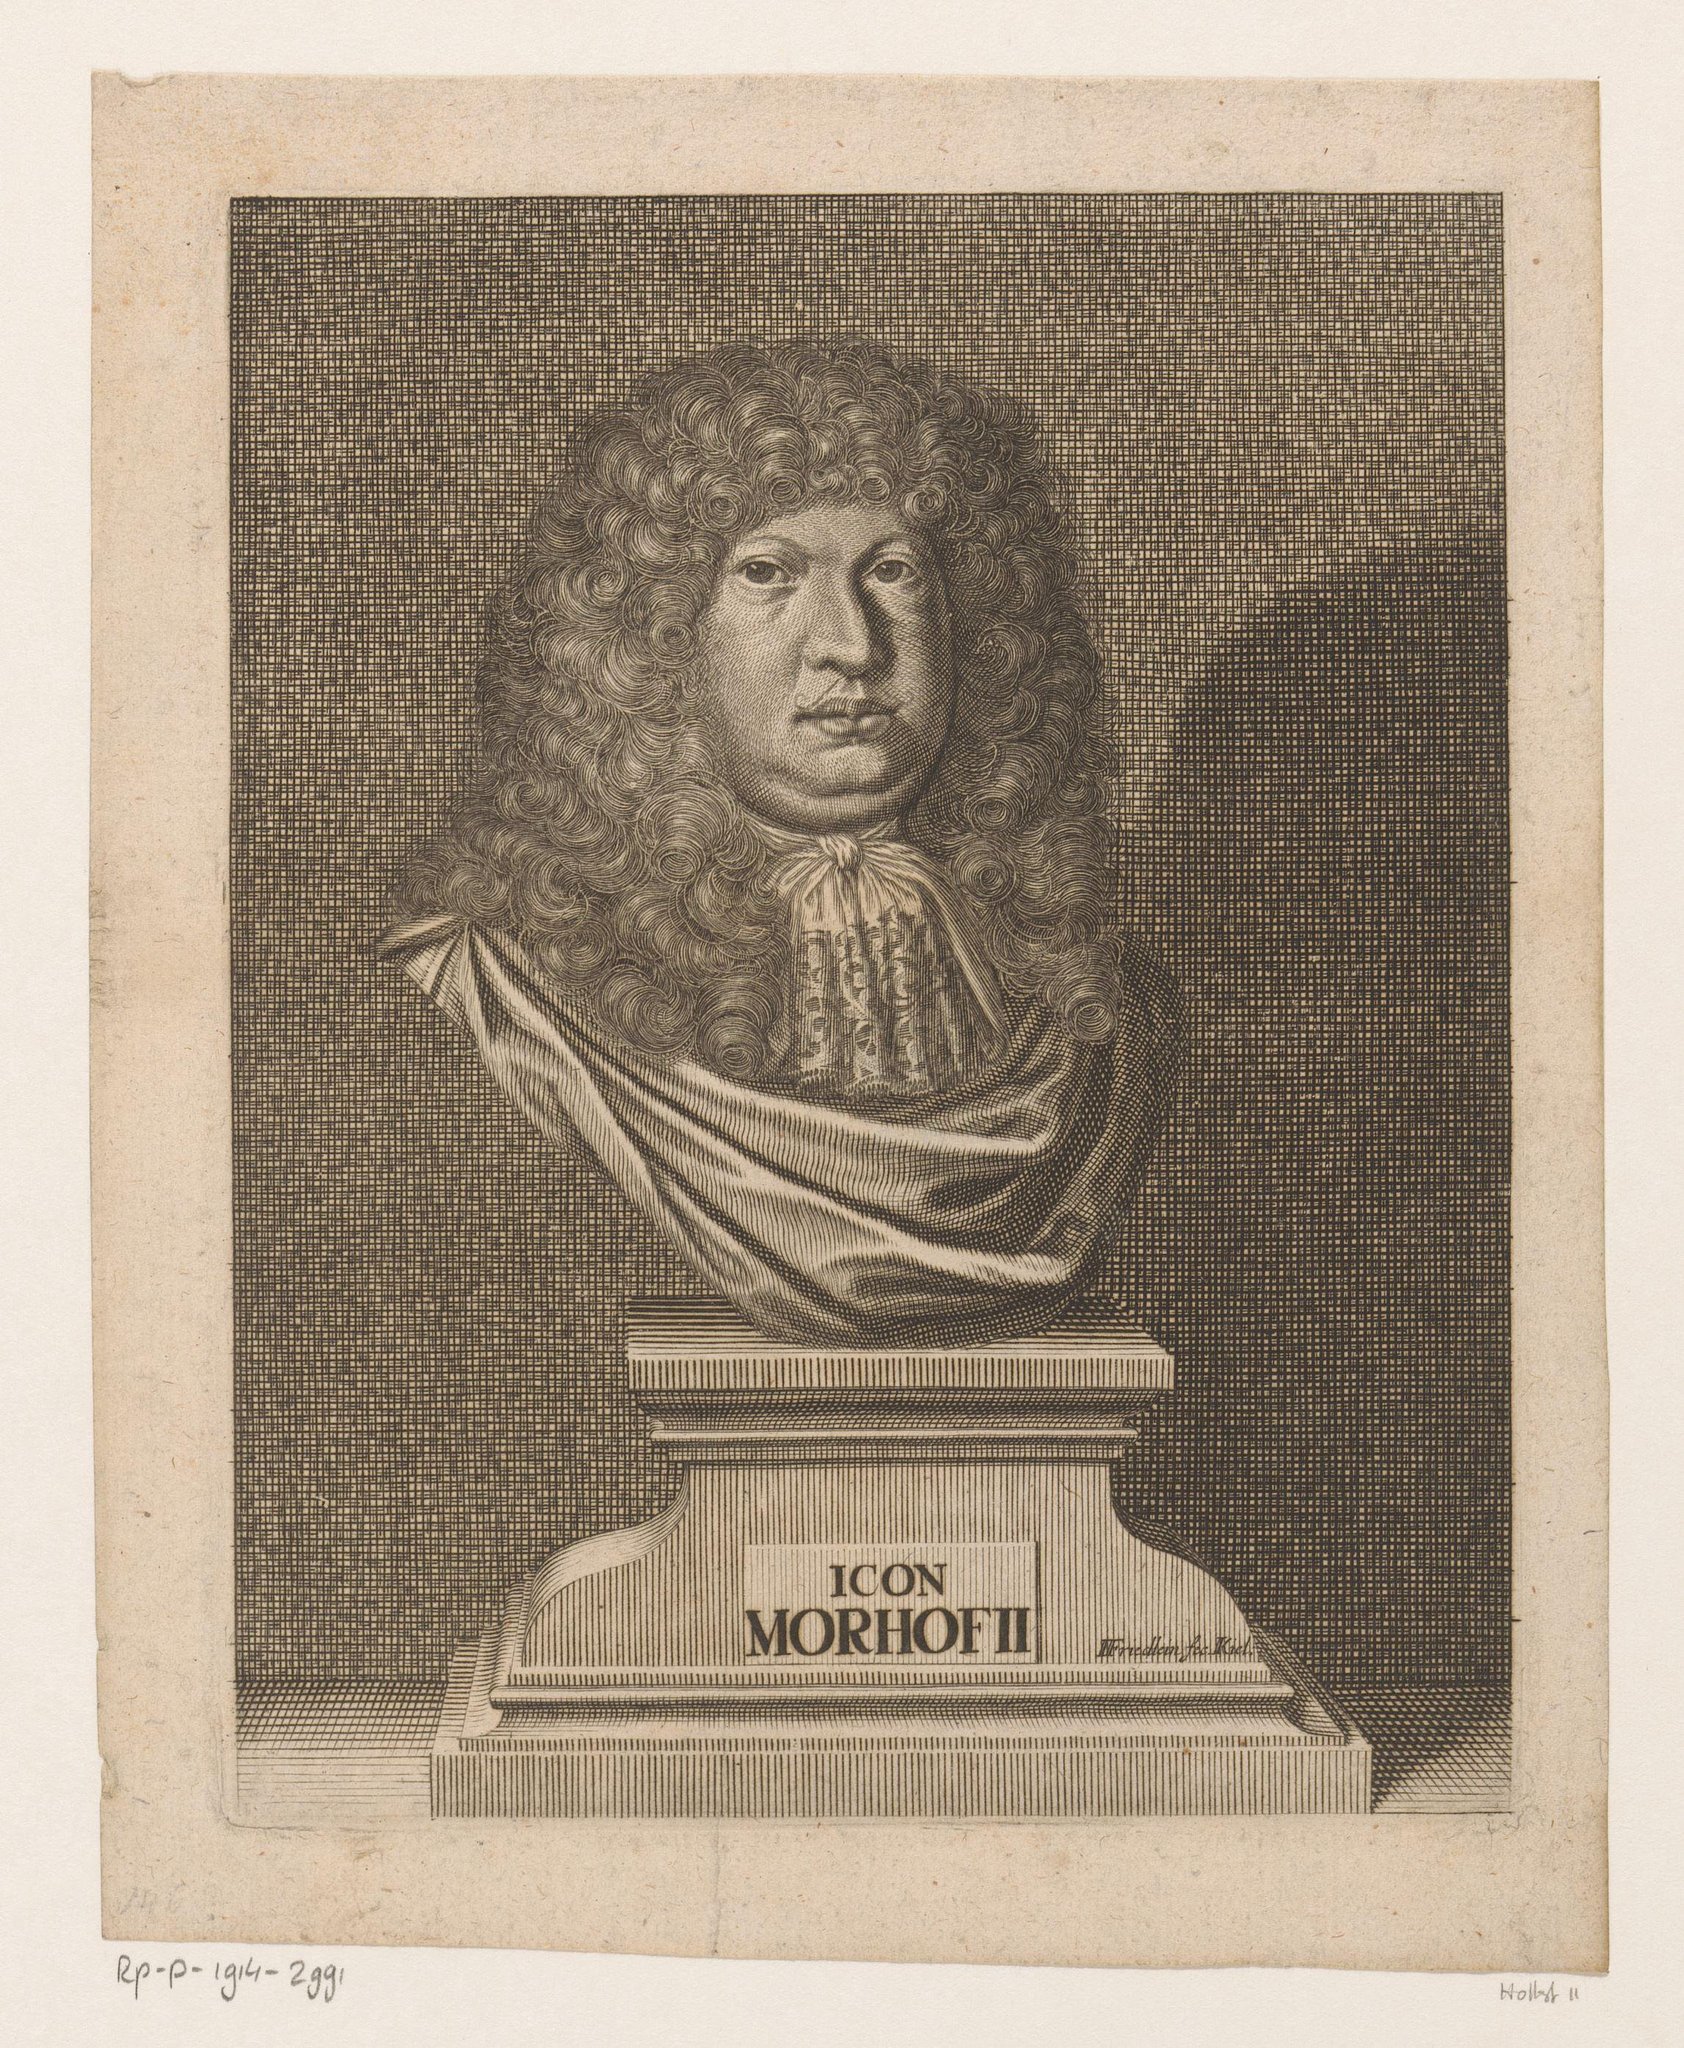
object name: print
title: Portret van Daniel Georg Morhof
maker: johann friedlein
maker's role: print maker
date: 1690-1695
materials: paper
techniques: engraving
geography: kiel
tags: daniel georg morhof, chest, bust, historical persons, sculpture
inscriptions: collector's mark: Lugt 2228